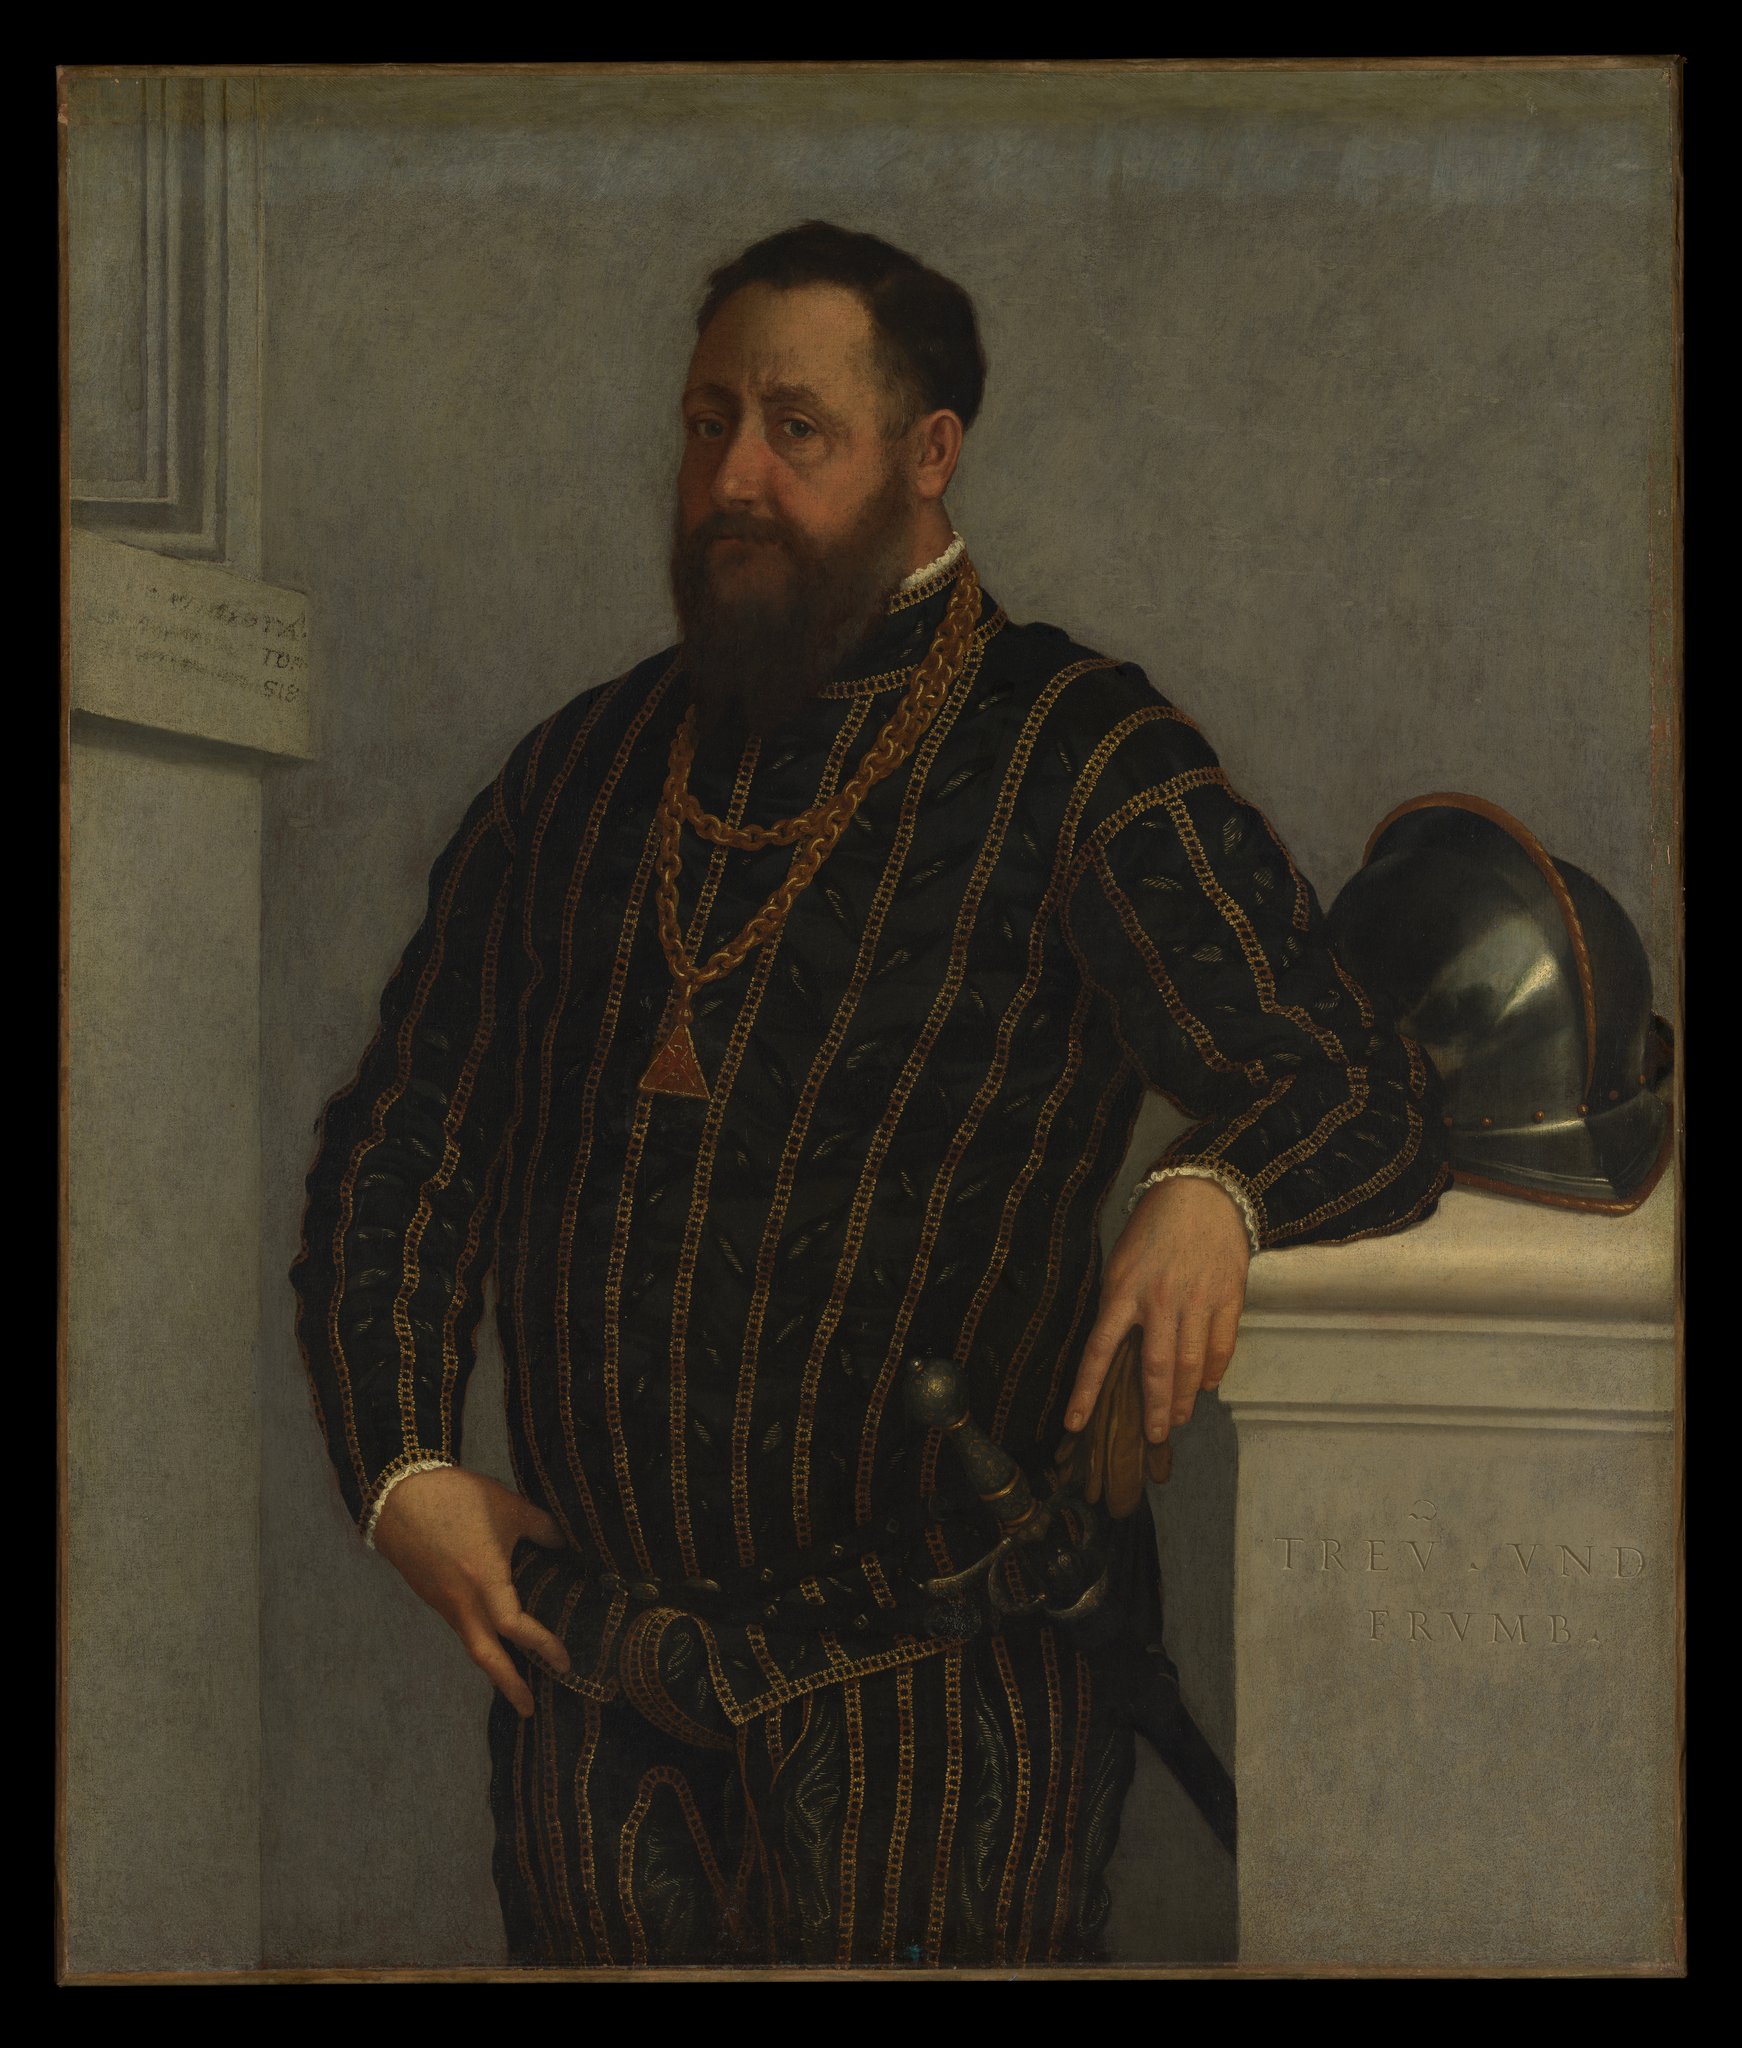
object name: painting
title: Portrait of a Man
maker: giovanni battista moroni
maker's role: artist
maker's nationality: italian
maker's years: 1524-1578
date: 1544-1578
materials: canvas, oil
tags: helmets,men,portraits